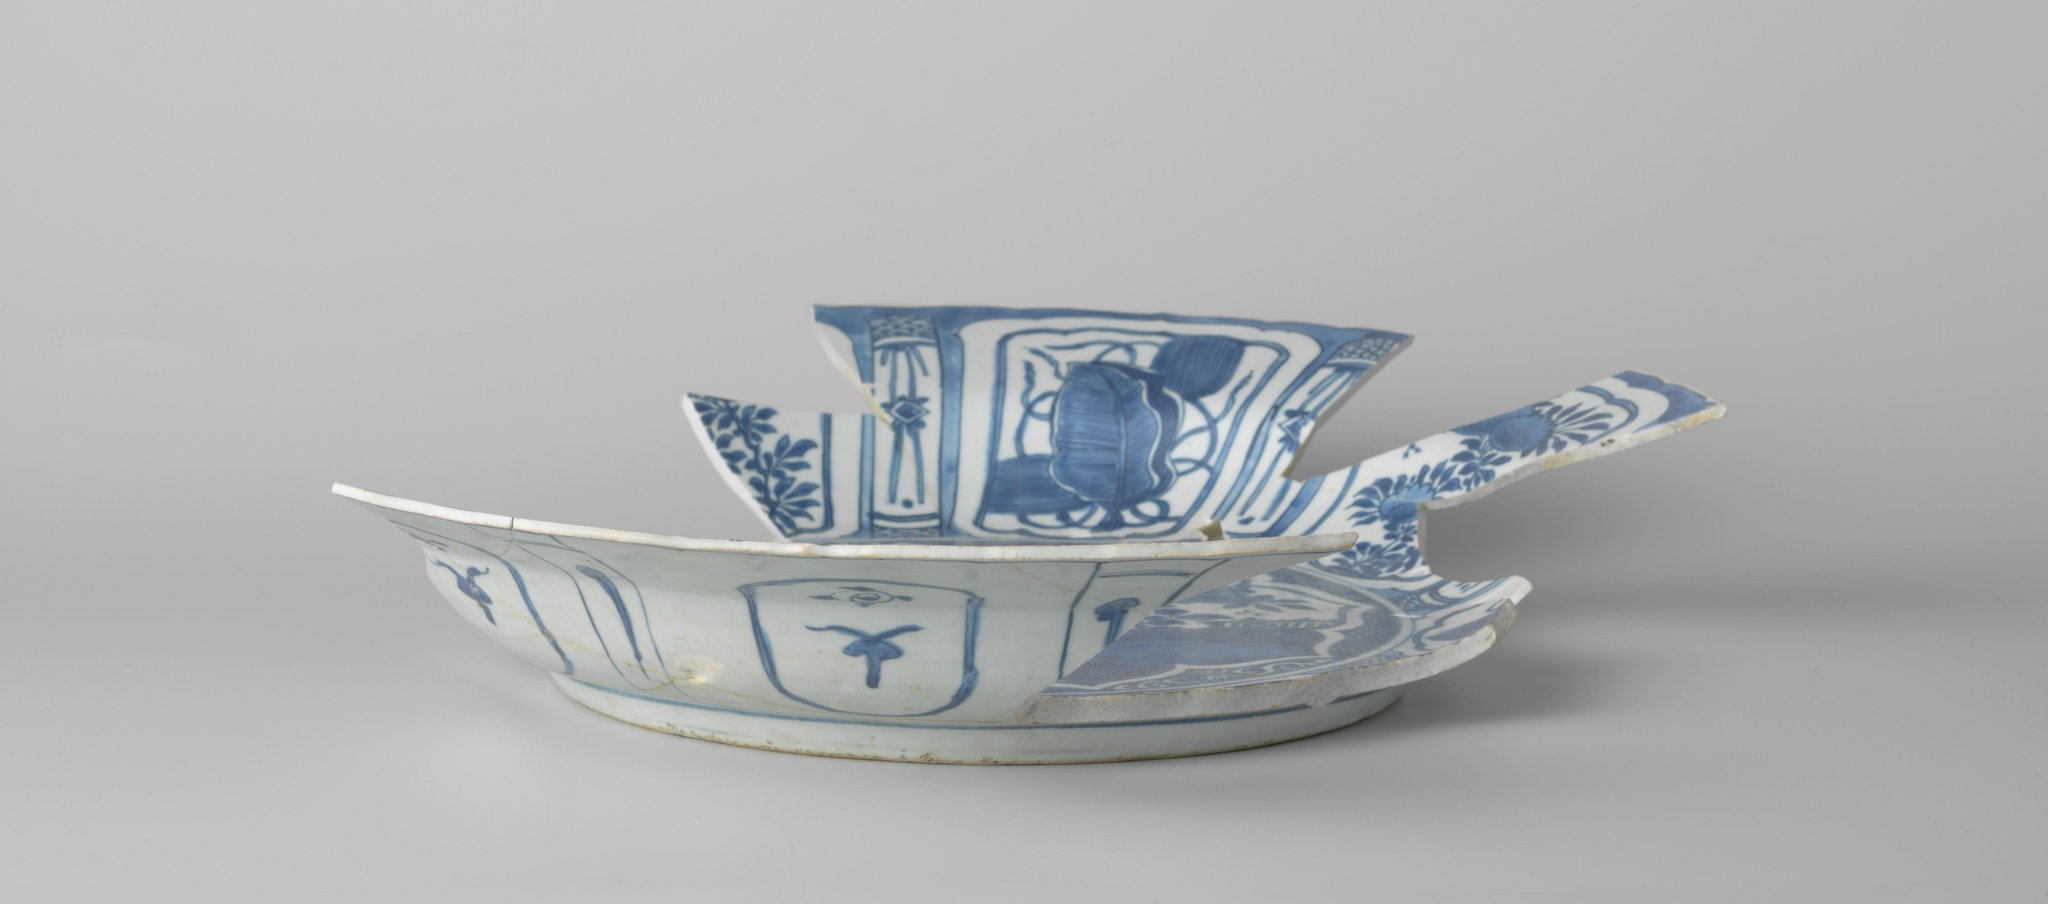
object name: platter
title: Fragment schotel uit V.O.C.-schip de 'Witte Leeuw'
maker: Anonymous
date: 1613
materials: bone china, porcelain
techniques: painted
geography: jingdezhen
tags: verenigde oostindische compagnie, sint-helena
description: Fragment schotel uit V.O.C.-schip de 'Witte Leeuw', 75% aanwezig. Grote schotel met een vlakke rand, een licht gechulpte lip en een ongeglazuurde bodem; gedecoreerd in onderglazuur blauw. De voetring is v-vormig en ongefacetteerd. In het plat een vogel bij de waterkant, omgeven door bloeiende planten. Rondom de voorstelling een accoladevormige band gevuld met geometrische patronen. Op de wand en rand afwisselend brede en smalle velden gevuld met geluksymbolen, bloemtakken en strikwerk.